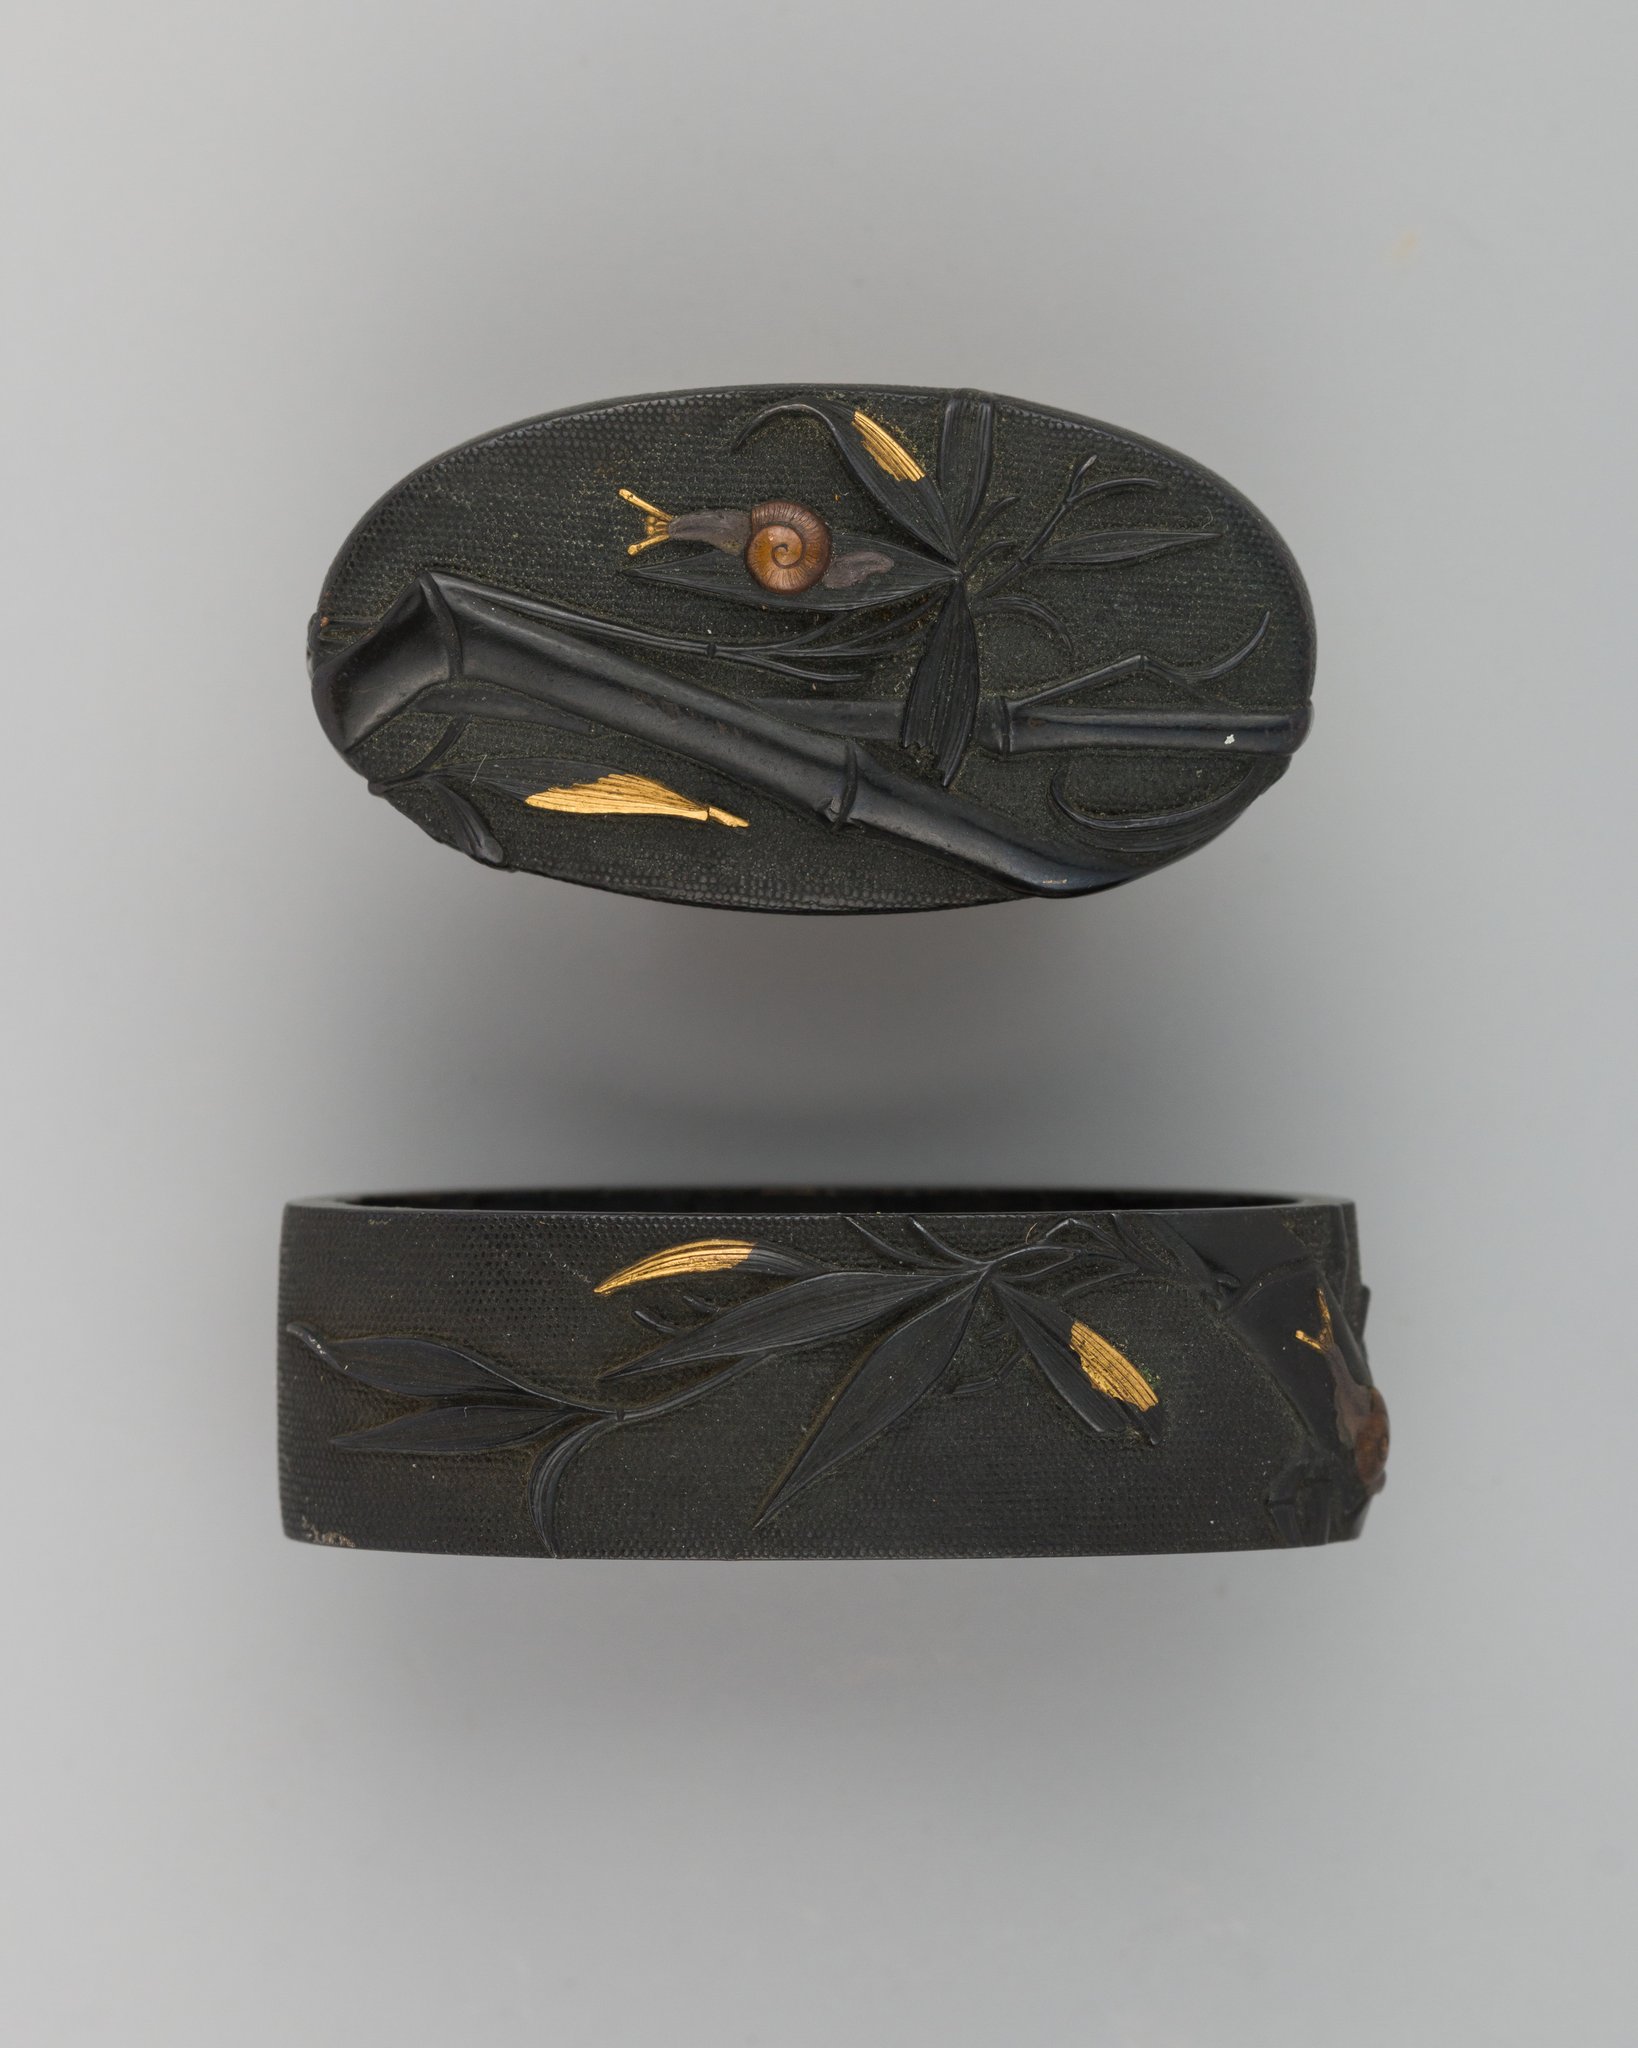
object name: sword hilt collar and pommel fuchigashira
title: Sword-Hilt Collar and Pommel (Fuchigashira)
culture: japanese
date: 1615-1868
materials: copper, gold alloy, gold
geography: japan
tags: snails,leaves